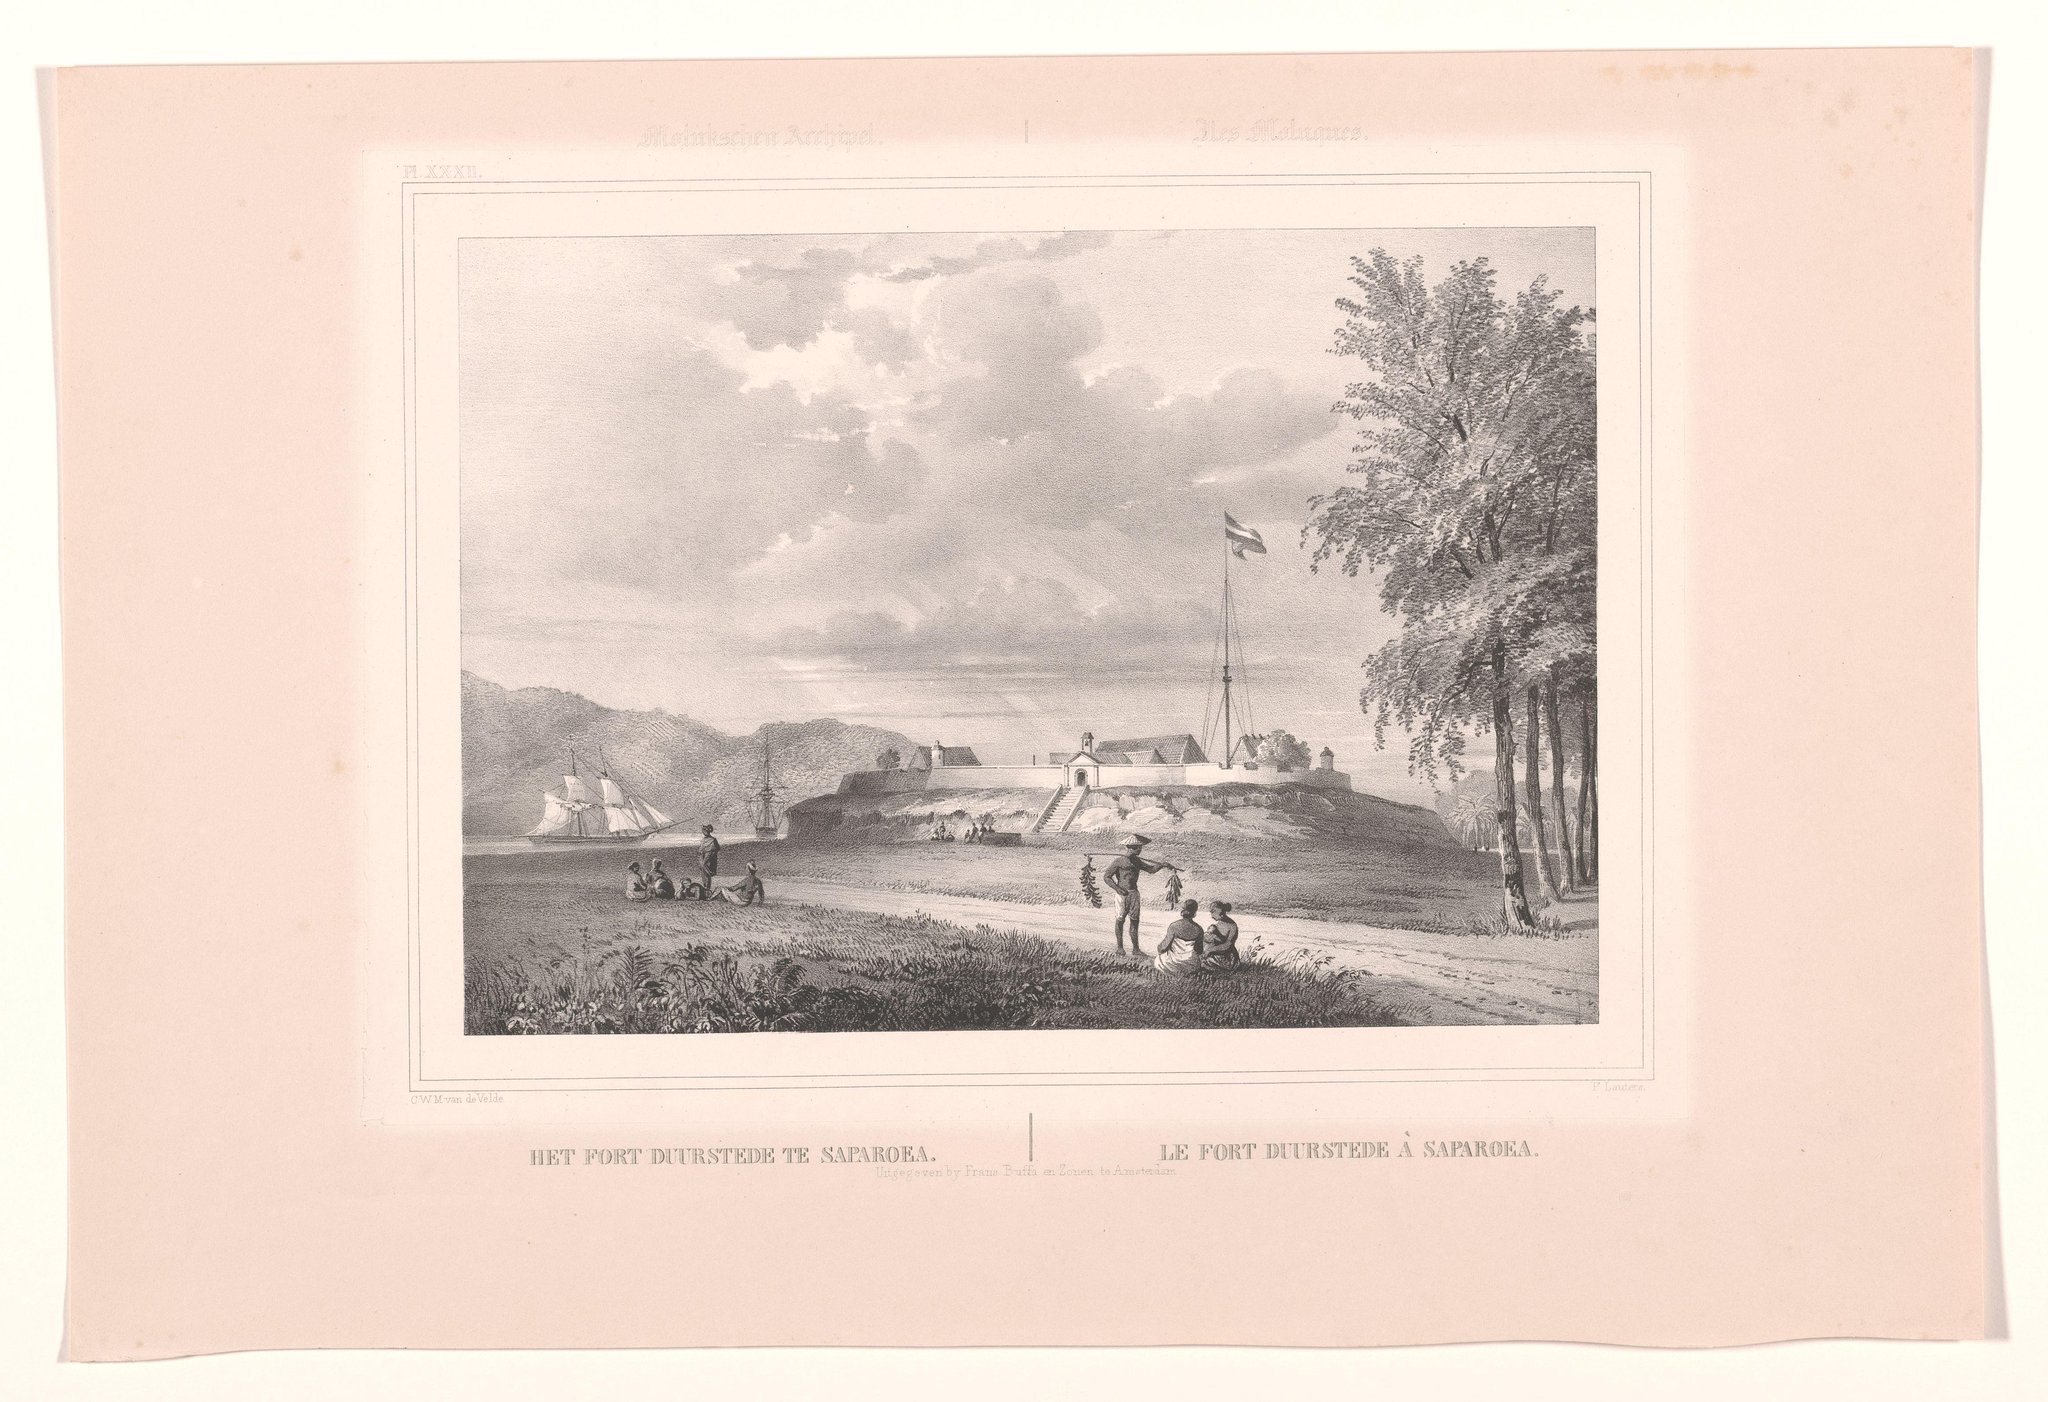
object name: print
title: Molukschen Archipel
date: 1843-1845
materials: paper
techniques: lithograph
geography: amsterdam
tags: fortress, flagpole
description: Aan een vlaggenmast wappert de Nederlandse vlag. Genummerd linksboven: Pl. XXXII. De prent maakt deel uit van een omslag met elf bladen.